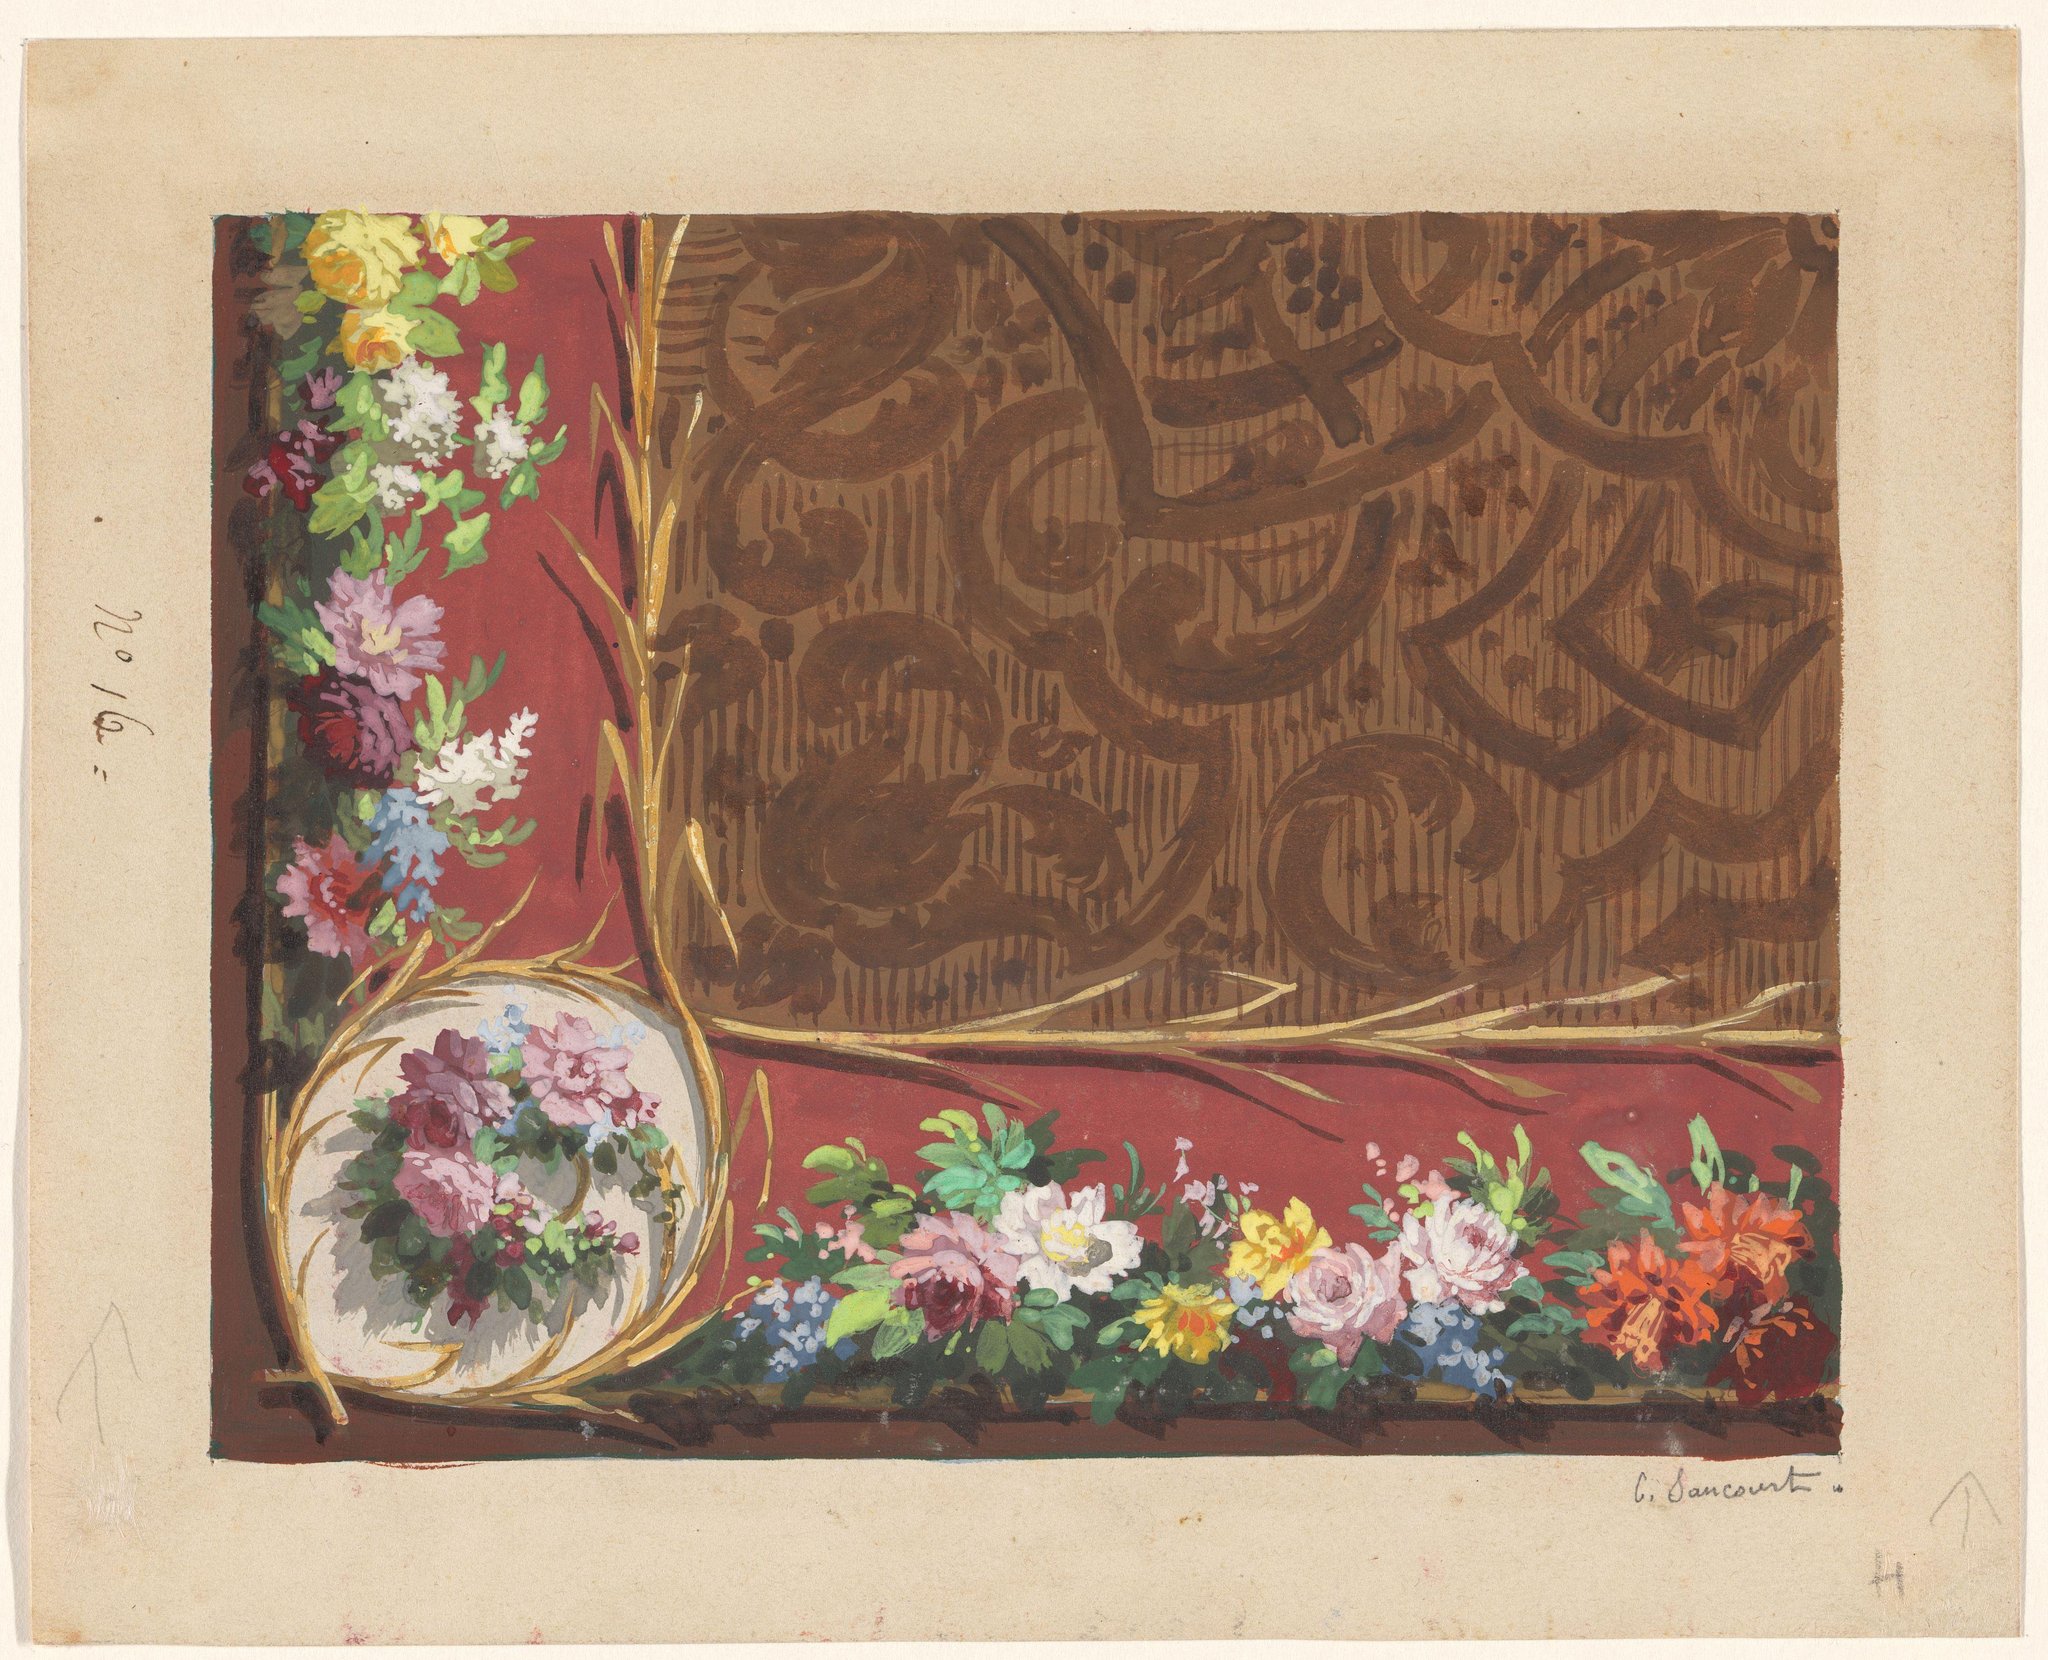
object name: design drawing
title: Ontwerp voor de hoek van een tapijt met een rechthoekig bruin middenveld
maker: c. sancourt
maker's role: draughtsman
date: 1850-1880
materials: gouache, graphite, paper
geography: france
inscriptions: signature: ‘C. Sancourt’